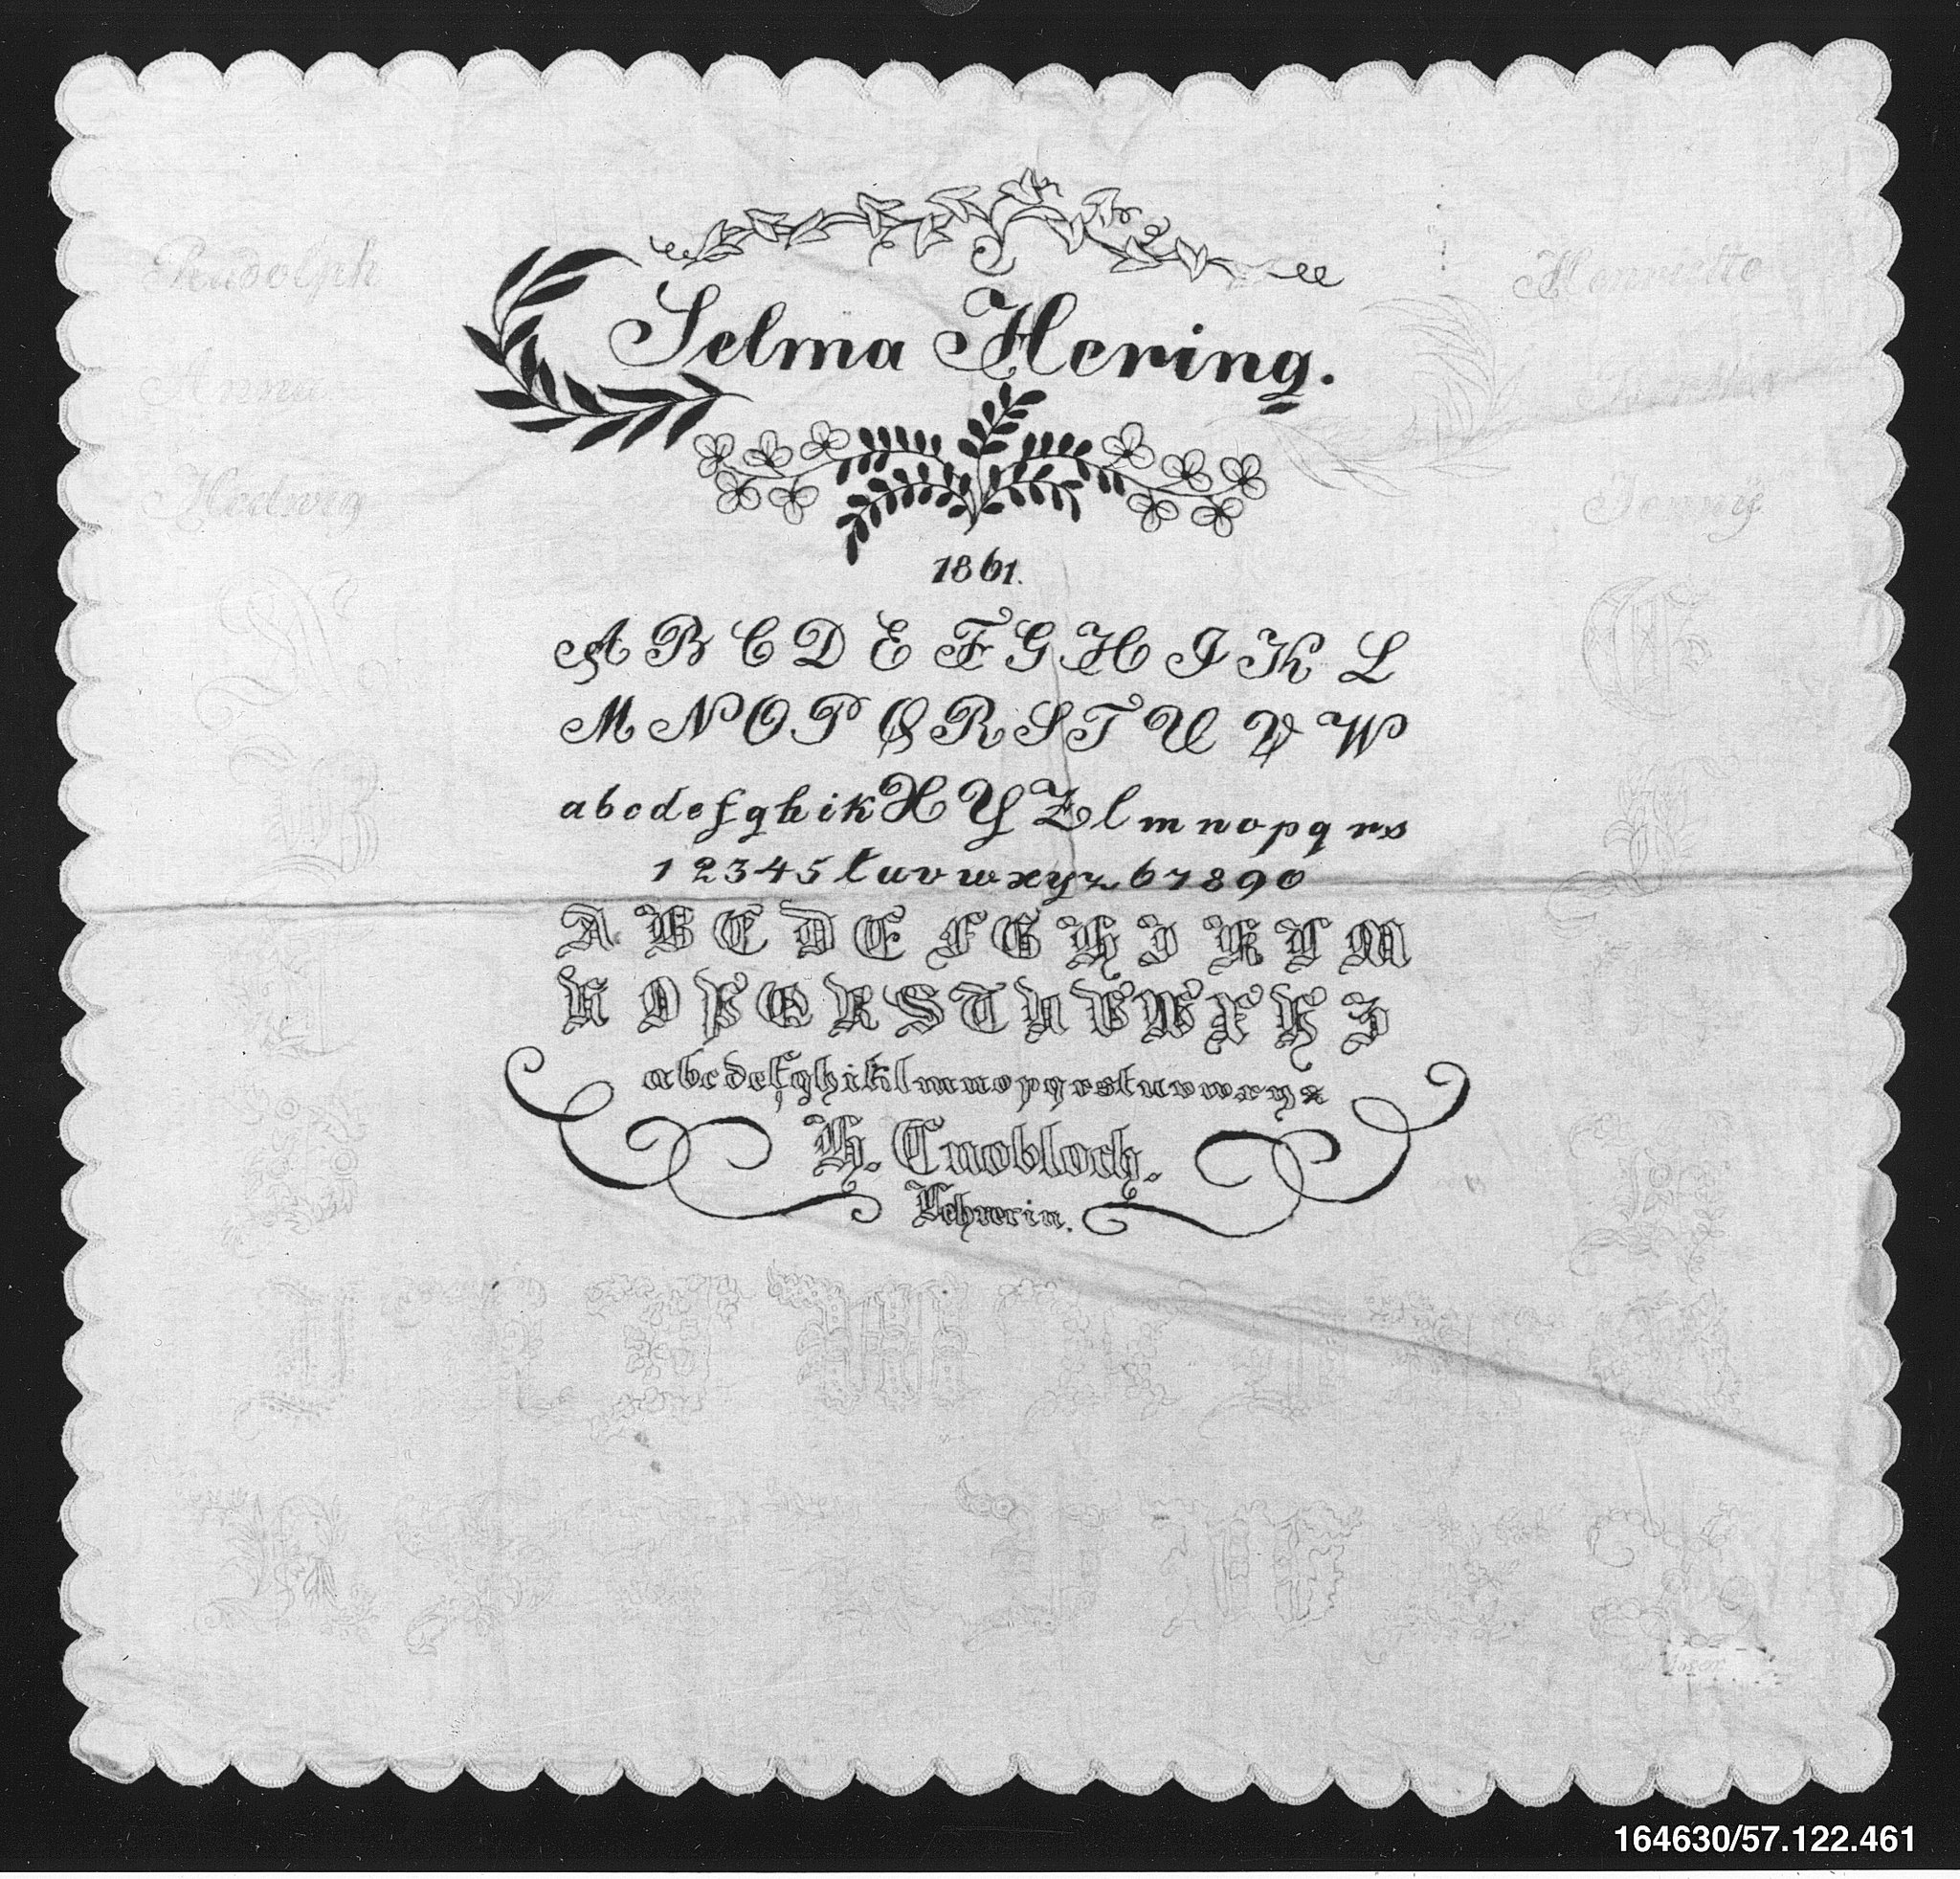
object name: sampler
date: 1861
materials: cotton, linen